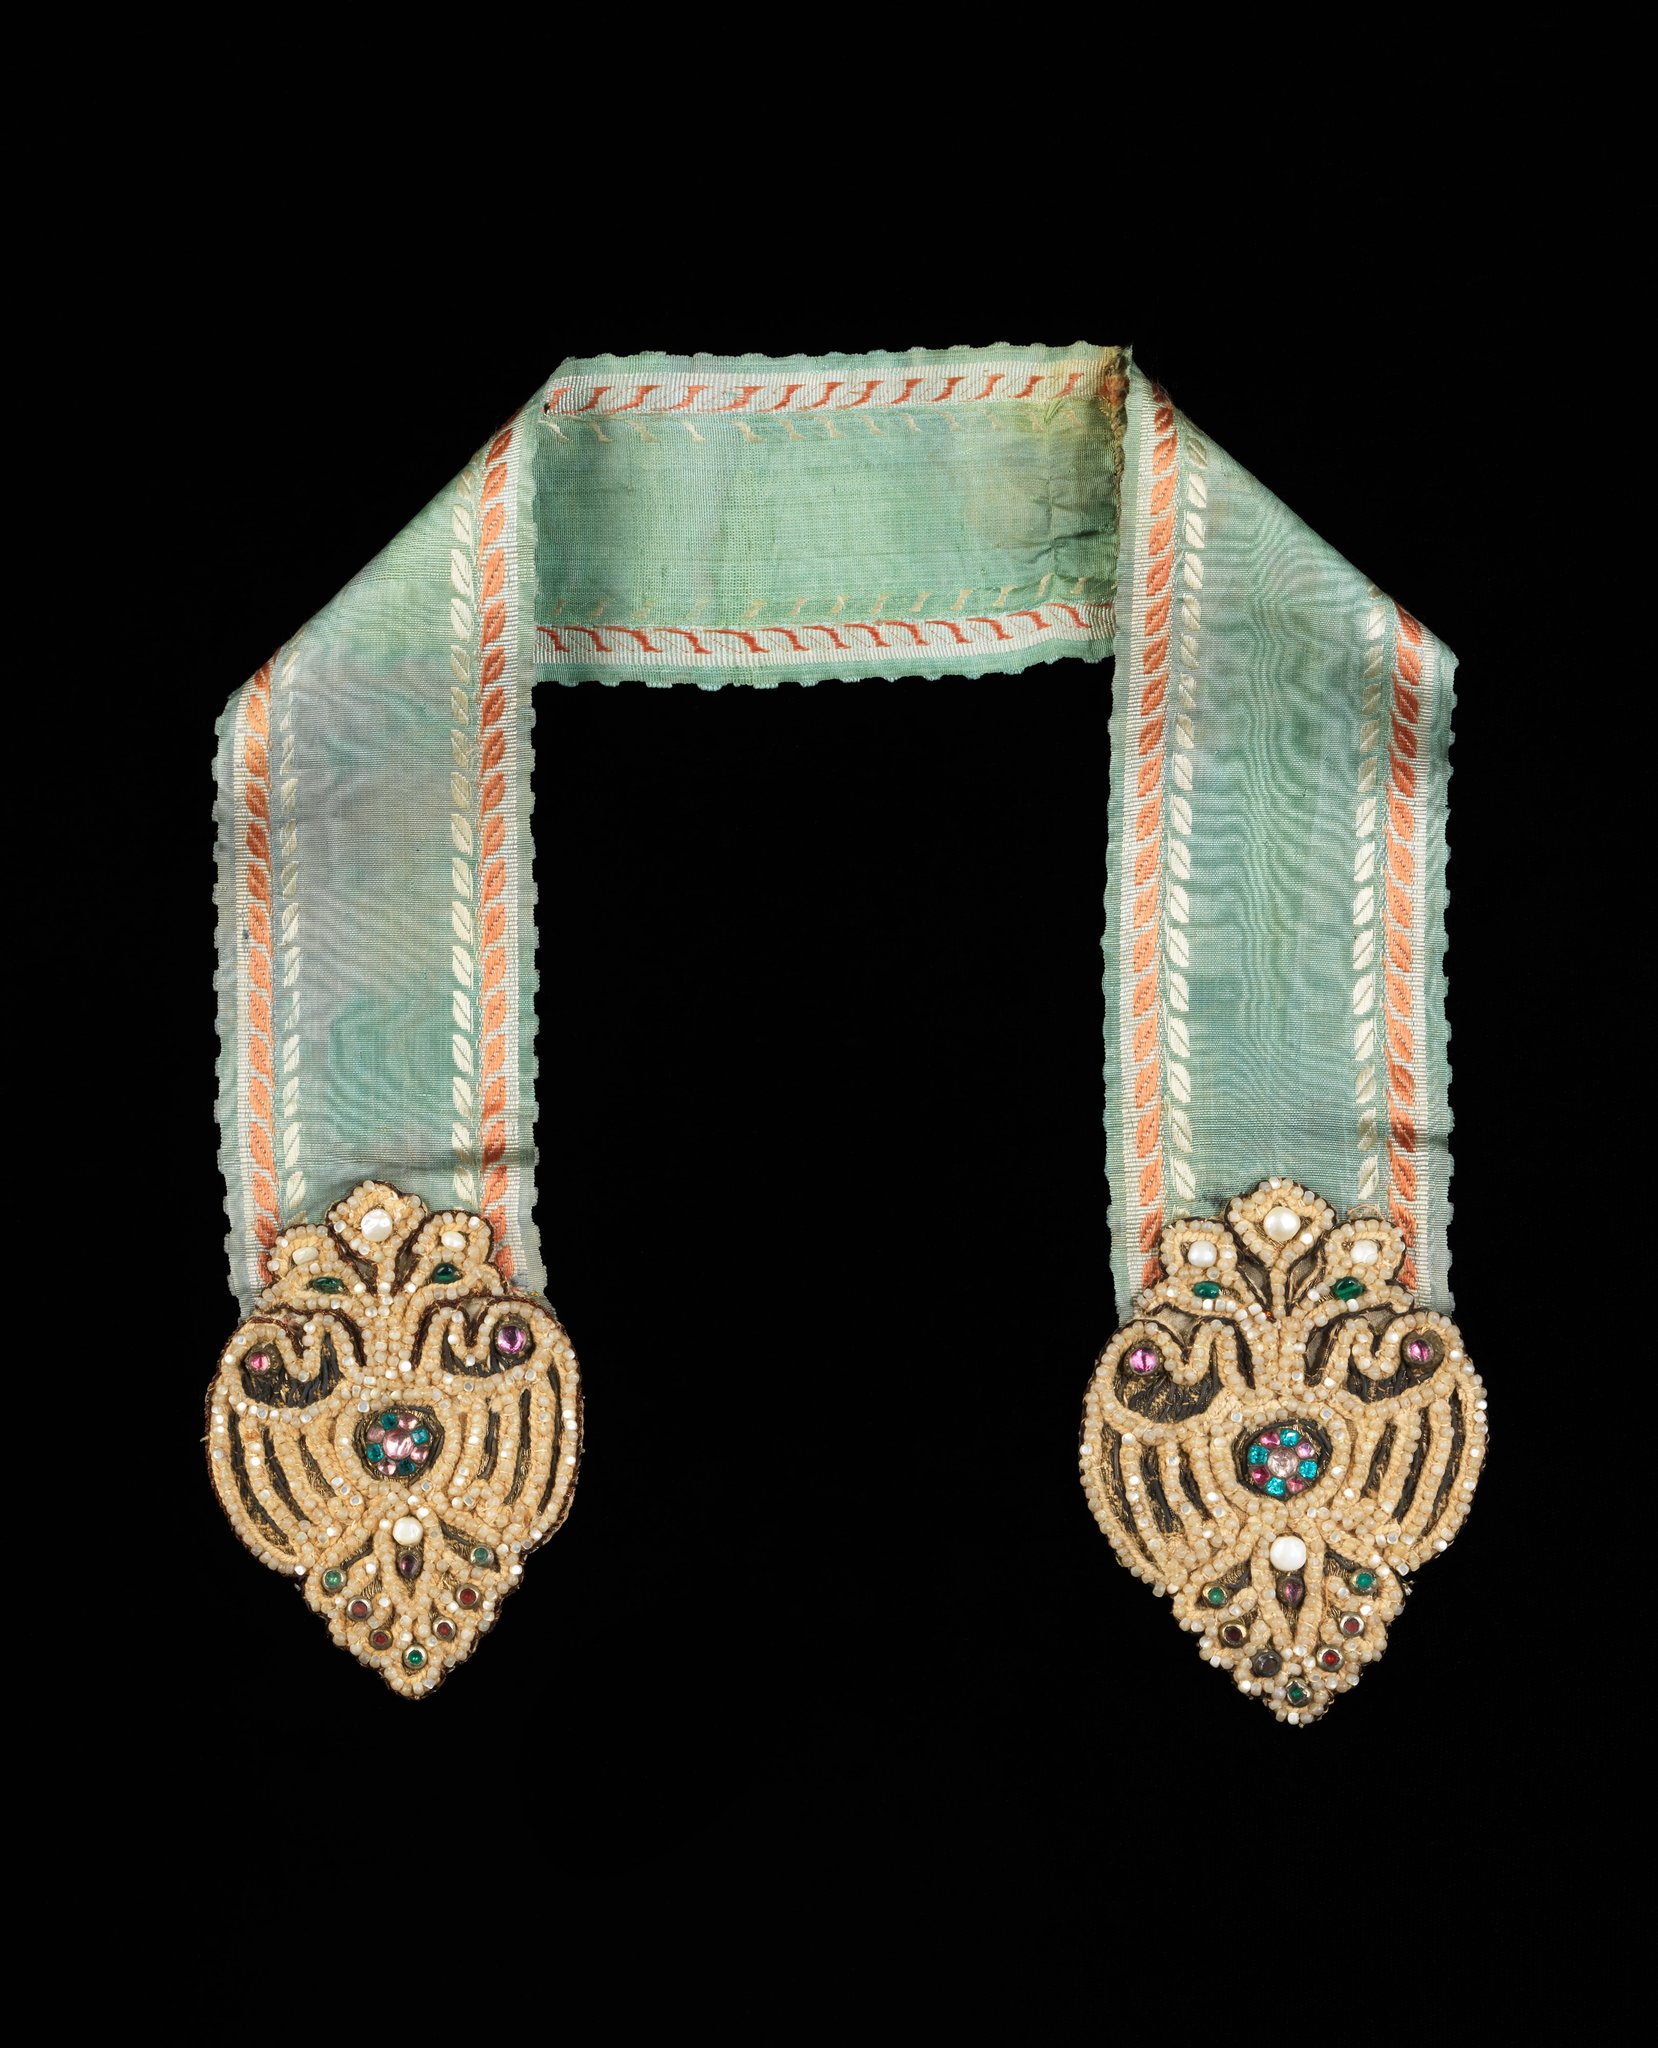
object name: hair accessory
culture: russian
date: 1801-1900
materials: cotton, glass, metal, mother of pearl, silk